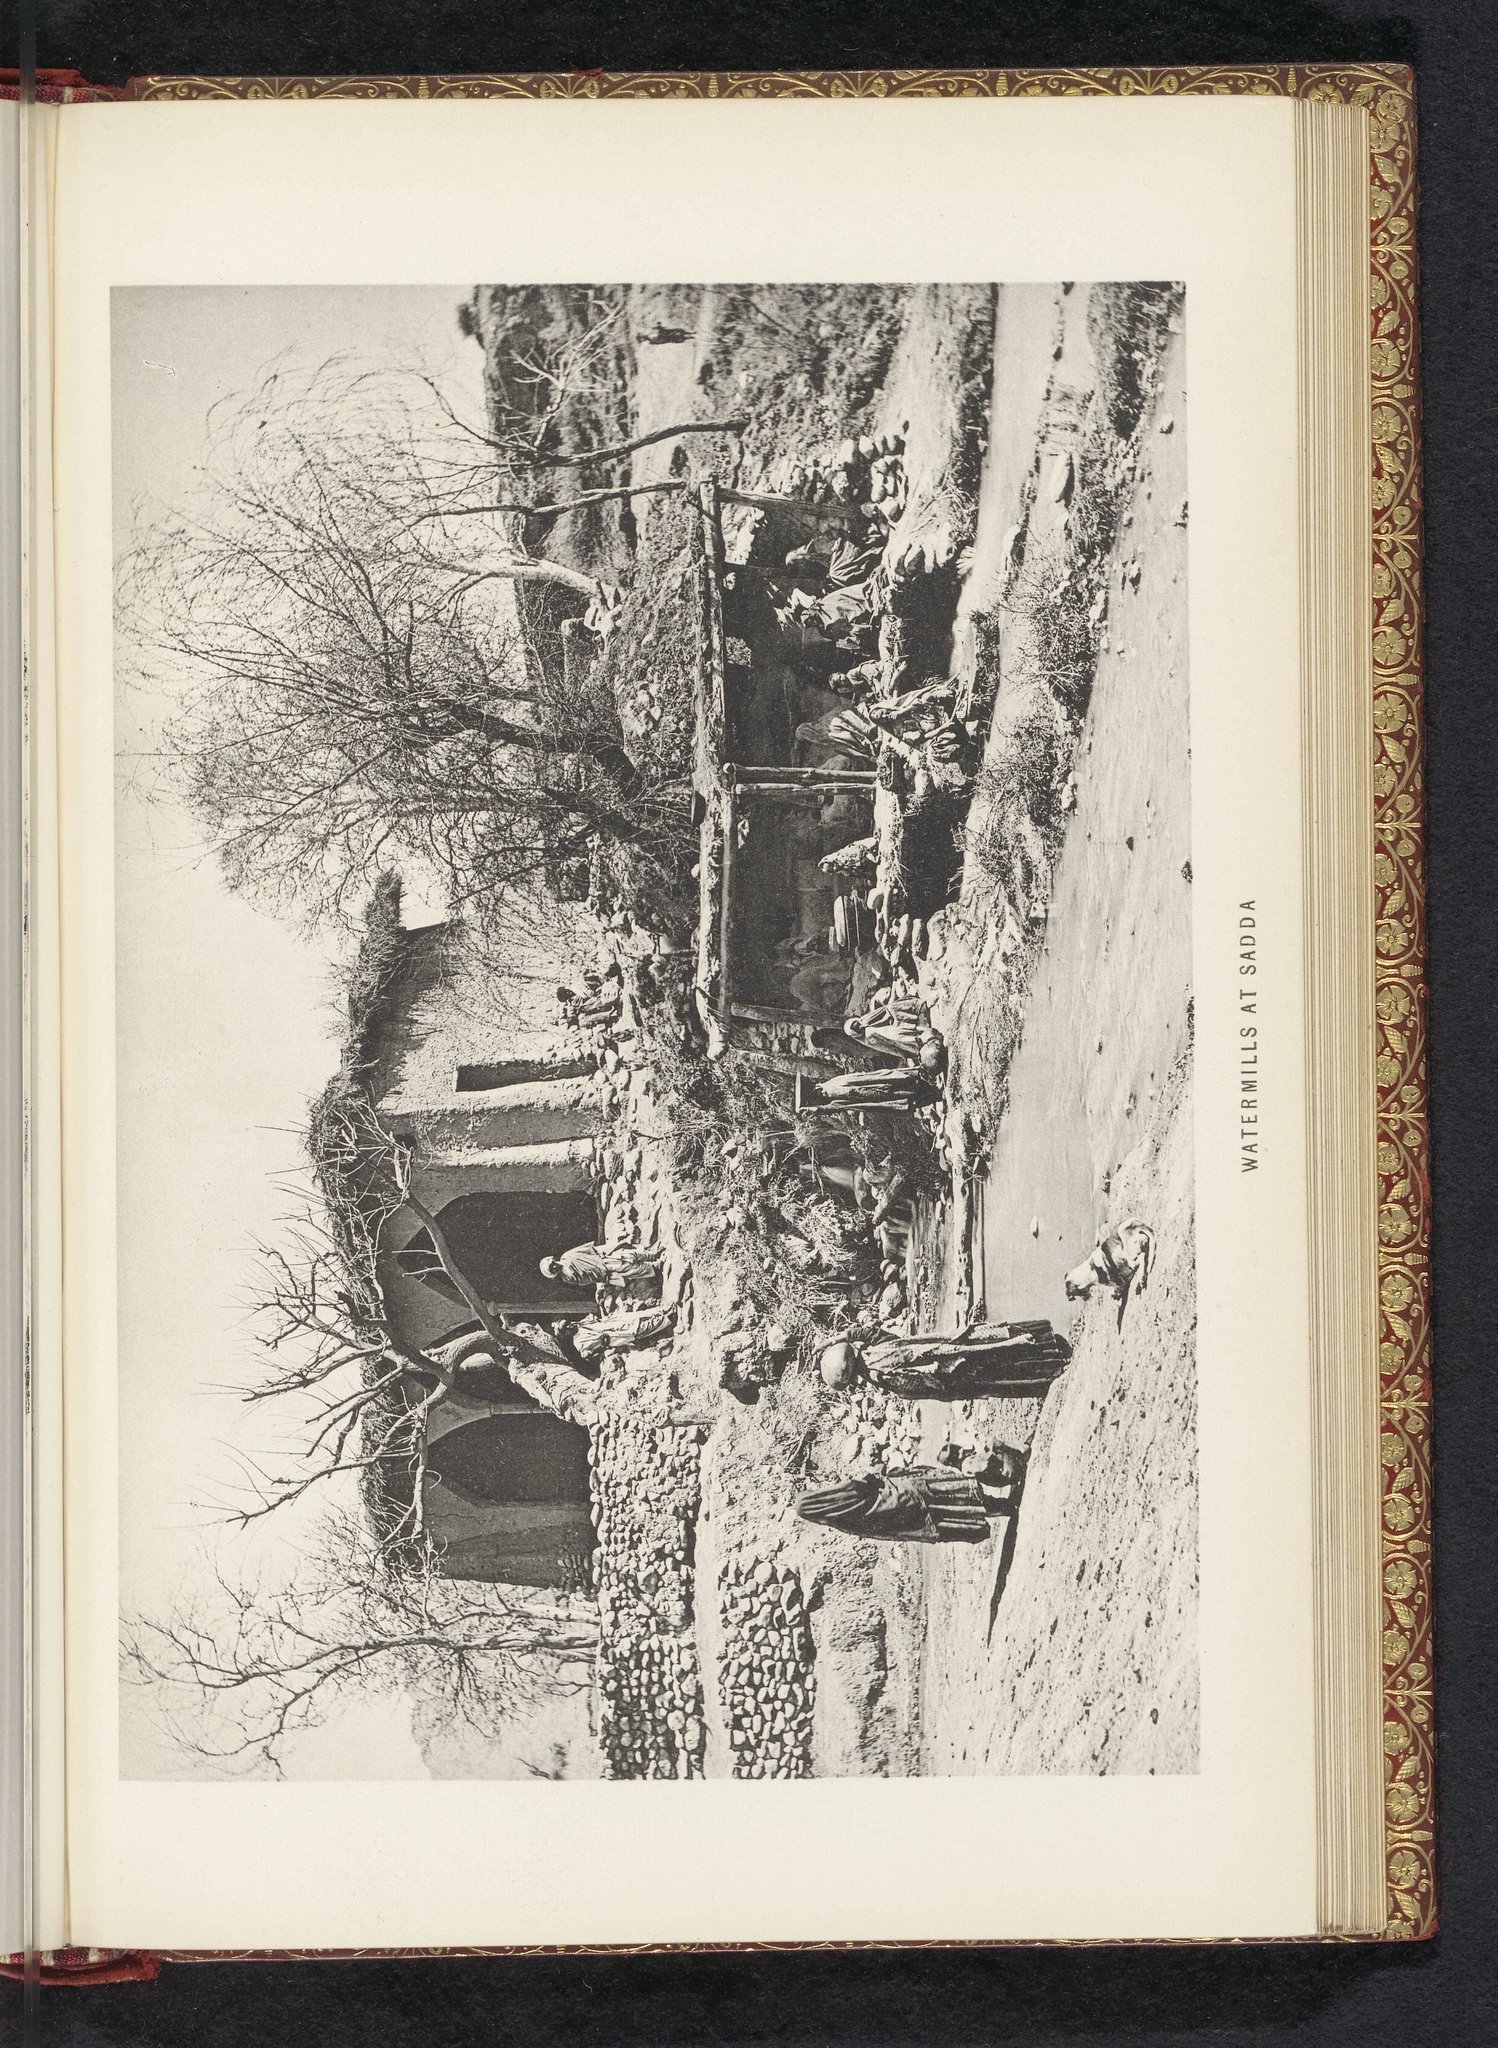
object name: page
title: Watermill along a stream at Sadda, Khyber Pakhtunkhwa, Pakistan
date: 1890-1895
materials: paper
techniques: photograph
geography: sadda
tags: brook, watermill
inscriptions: caption: ‘WATERMILLS AT SADDA’